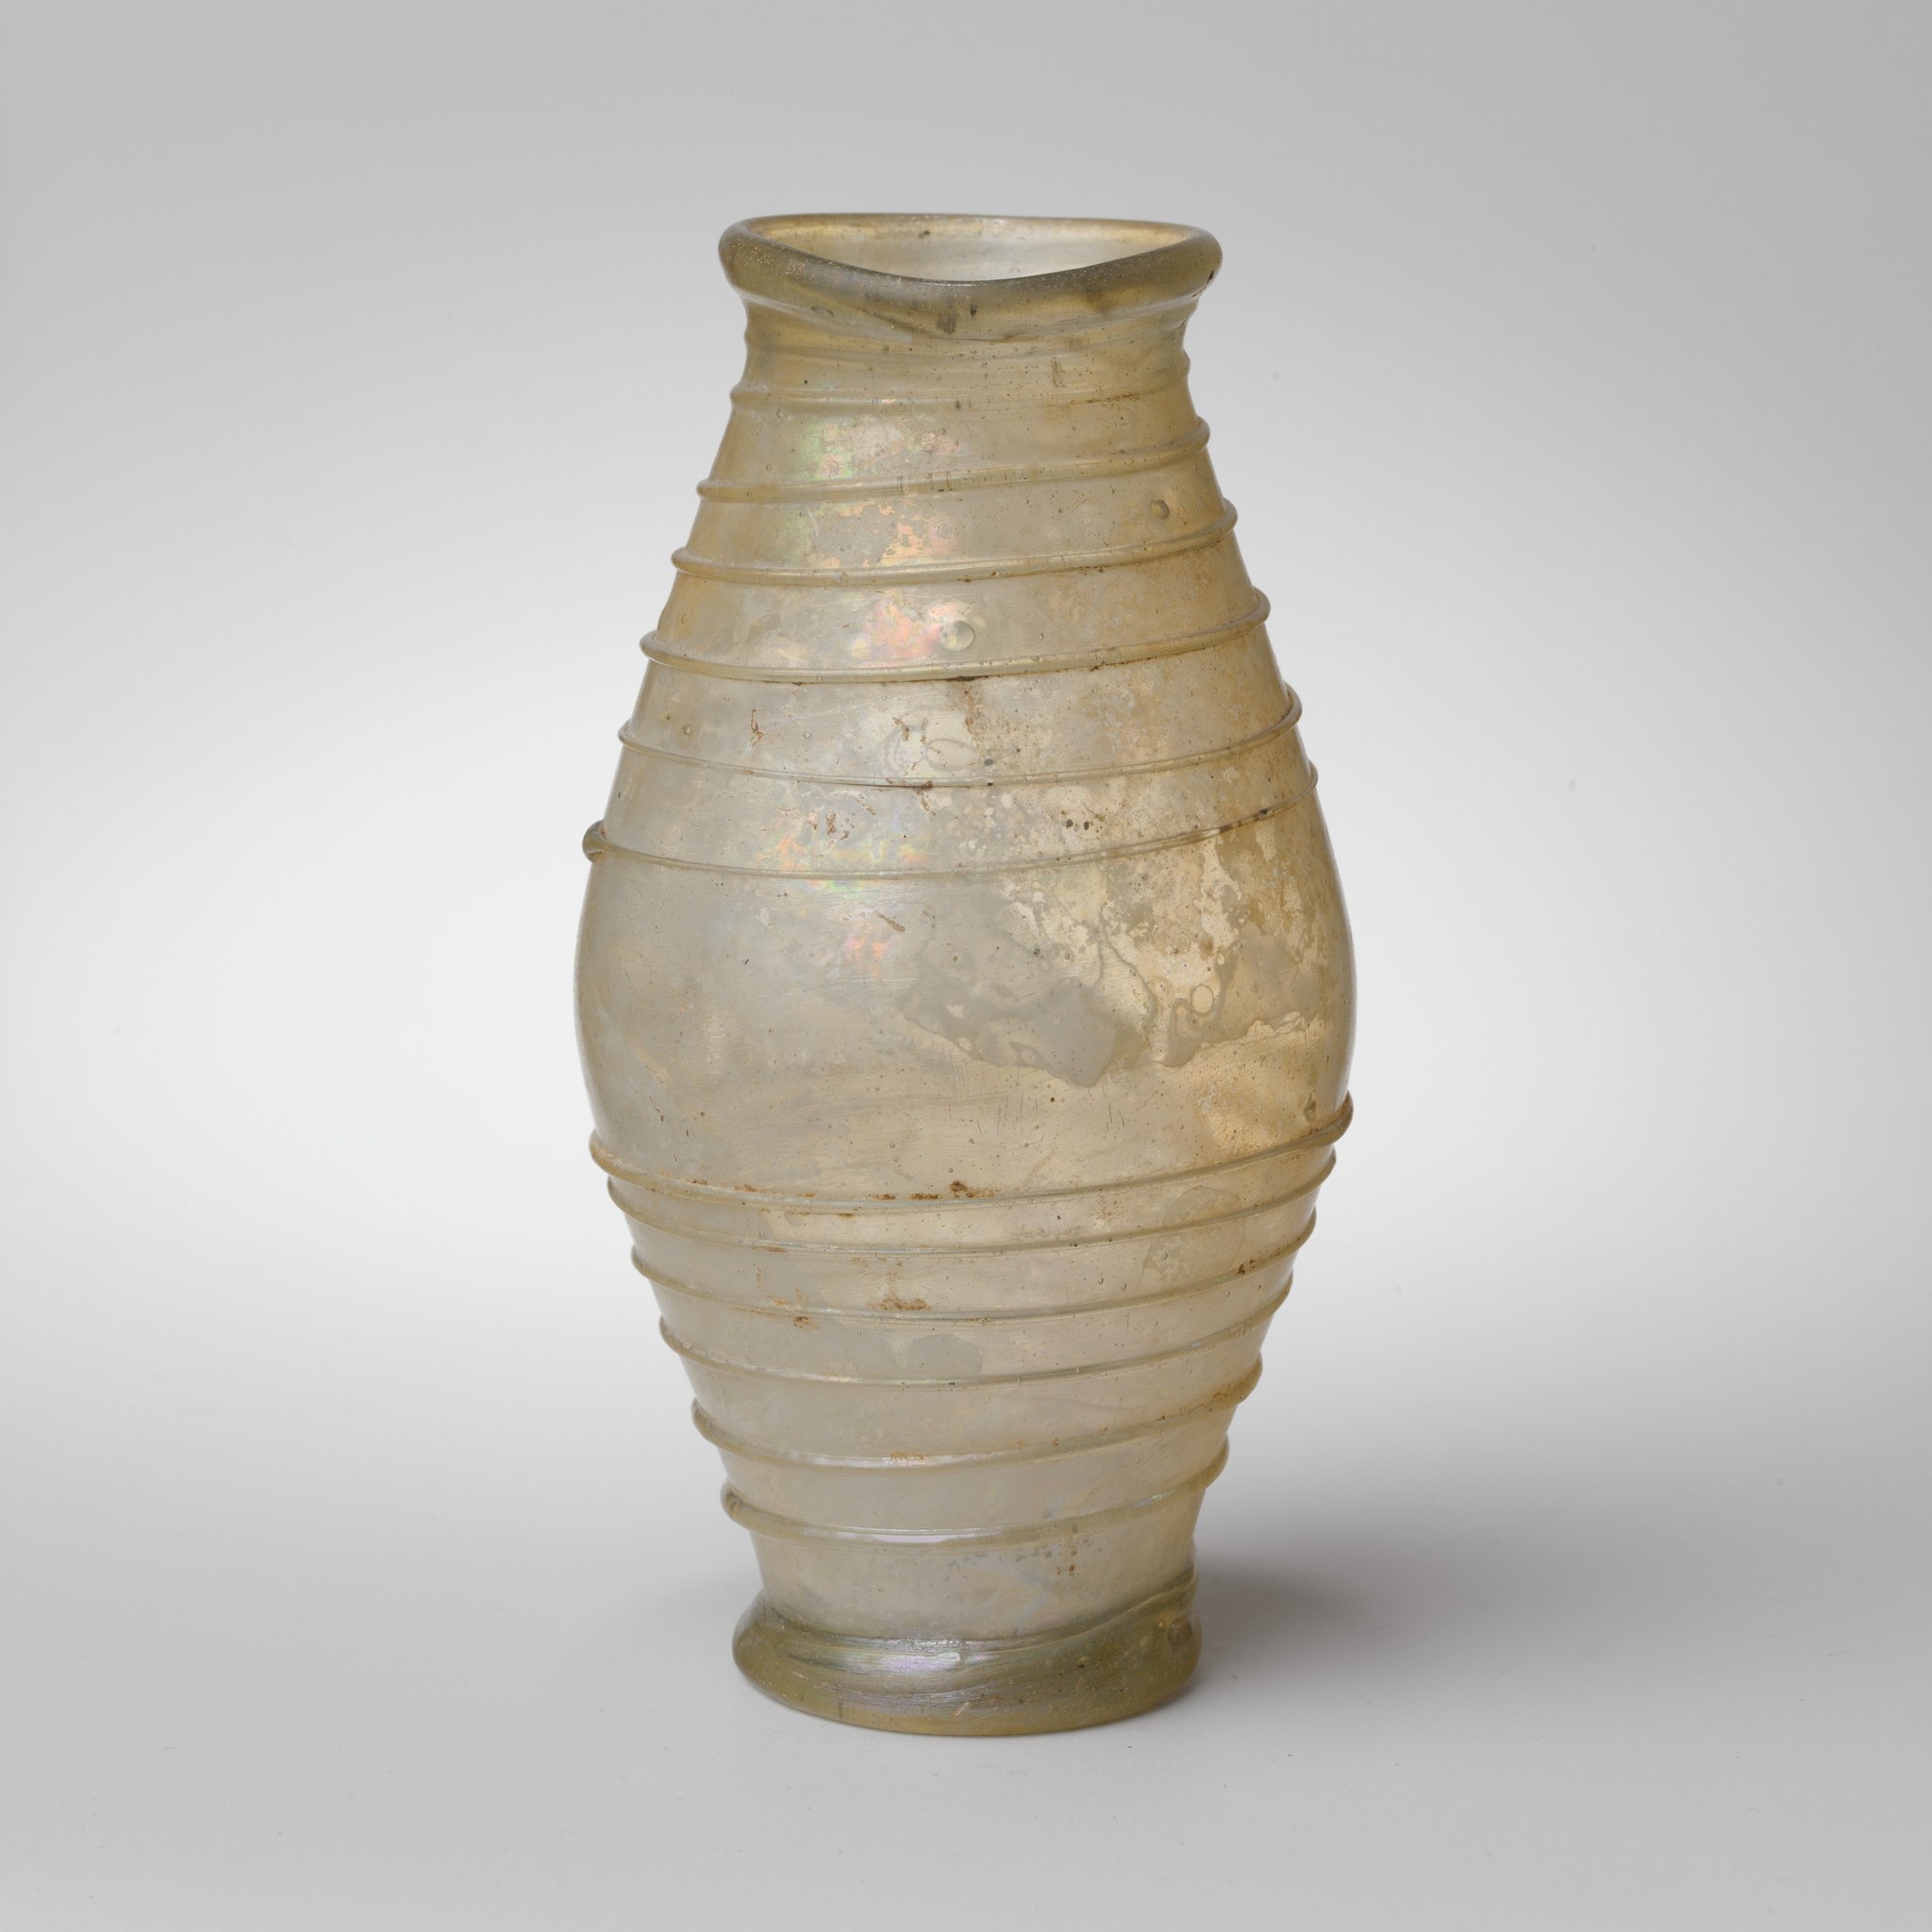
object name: jar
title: Glass barrel-shaped jar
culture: roman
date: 101-200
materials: glass